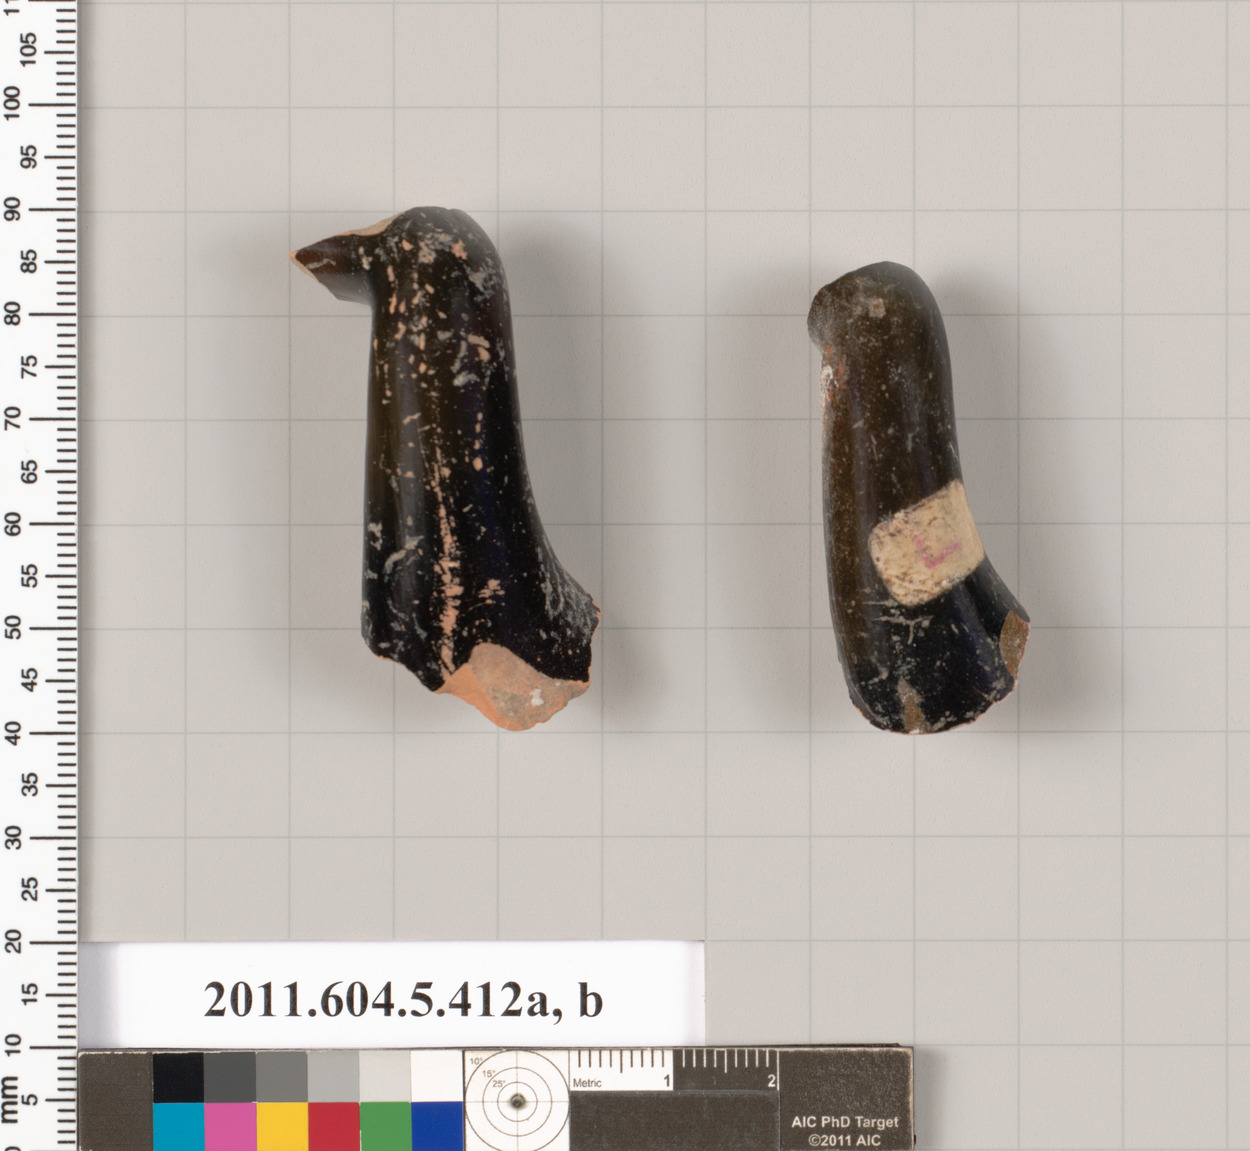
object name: kylix fragment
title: Terracotta fragments of kylikes (drinking cups)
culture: greek, attic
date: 600-401 BCE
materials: terracotta